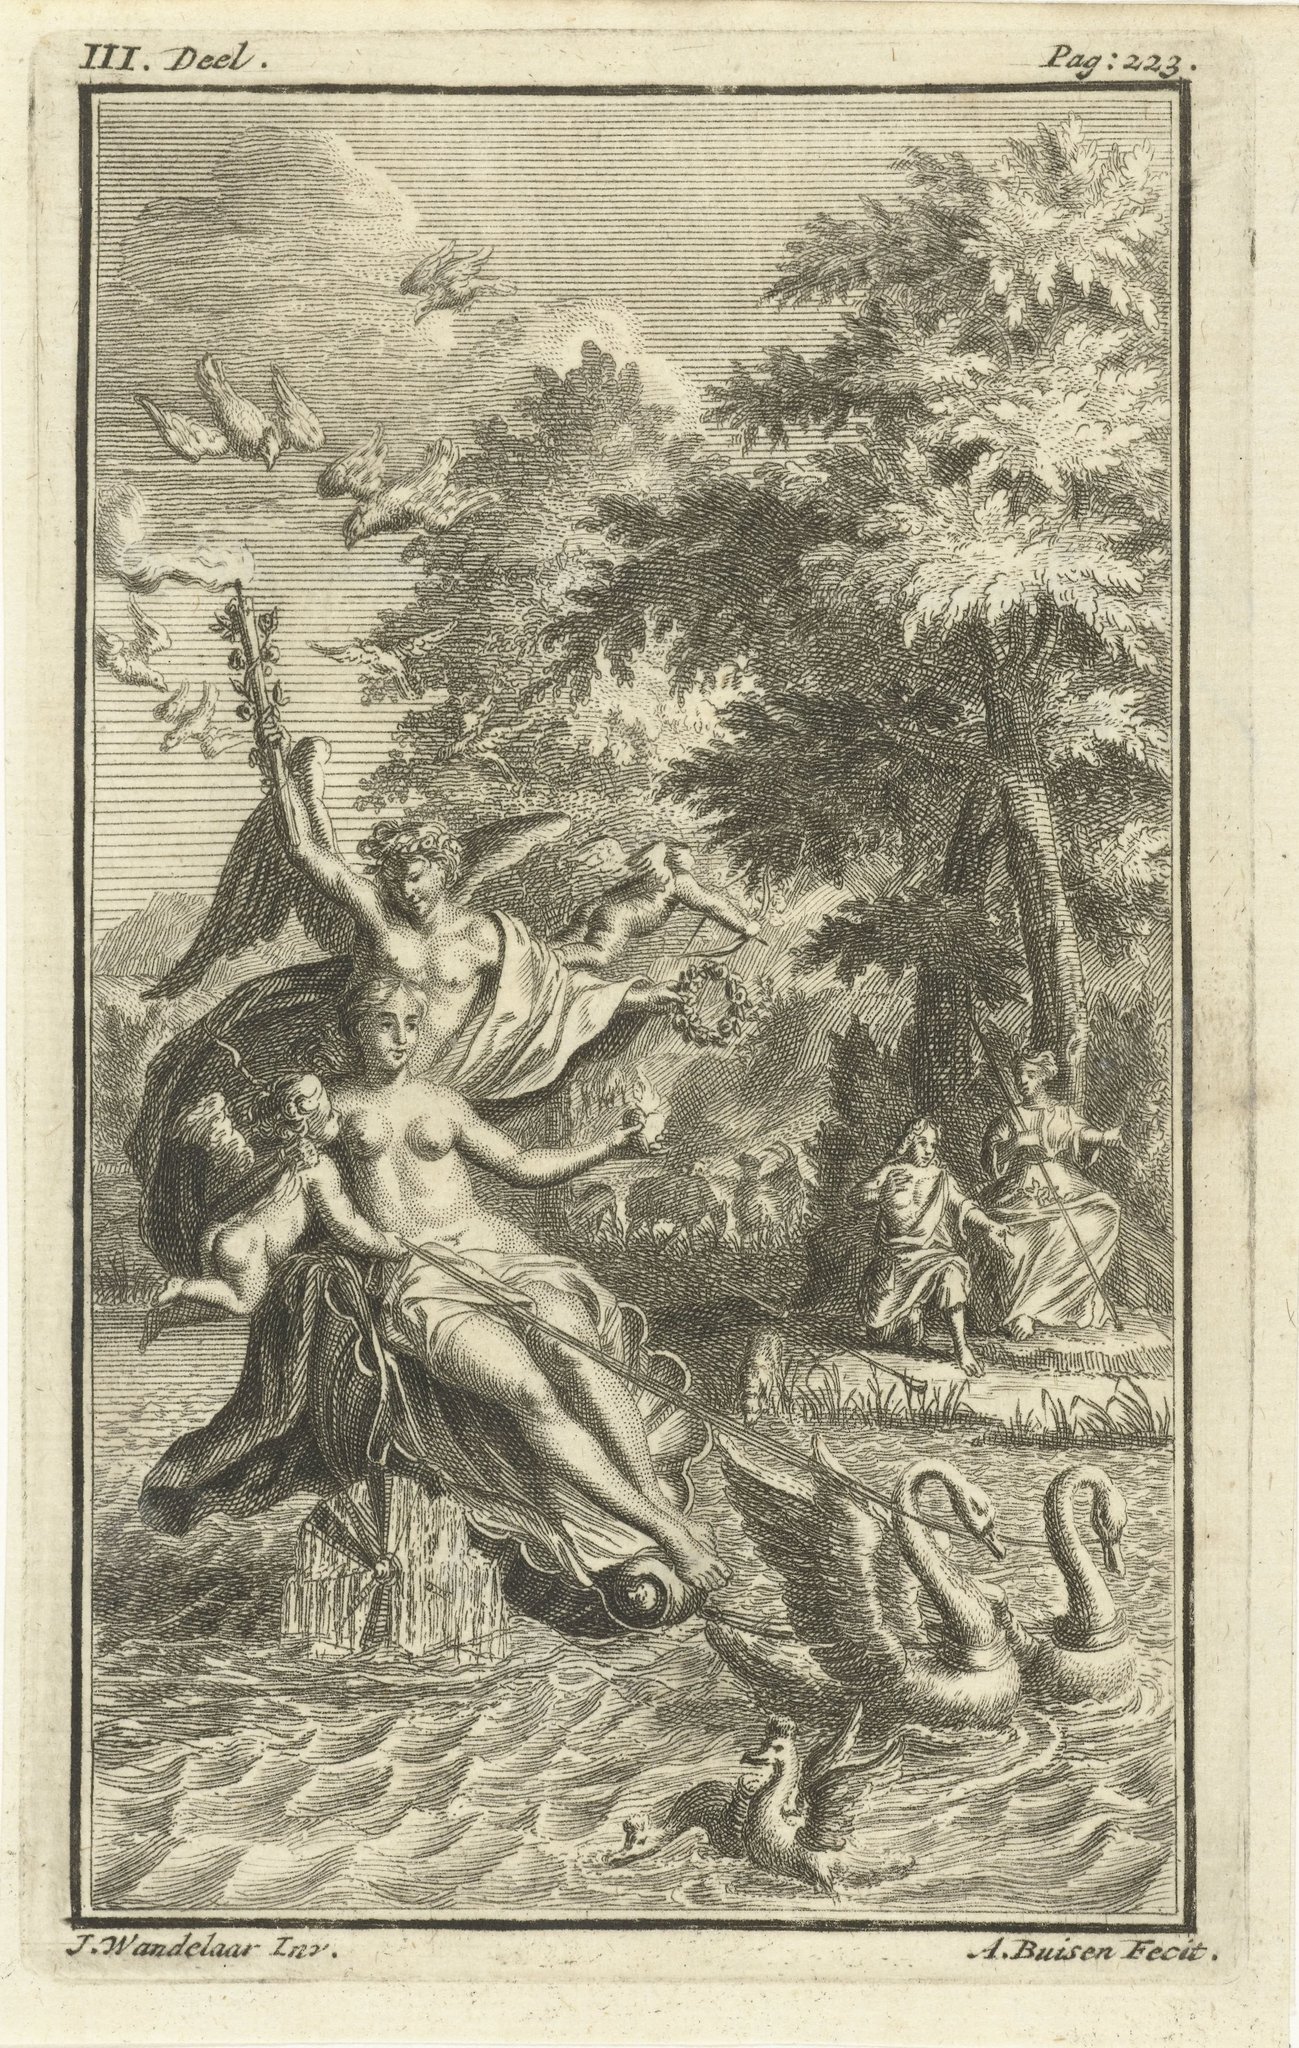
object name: print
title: Huwelijksaanzoek met Venus en Amor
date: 1723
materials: paper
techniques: engraving, etching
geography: amsterdam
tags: cupid shooting a dart, man kneeling before his beloved (proposing), venus and cupid (cupid not being mere attribute)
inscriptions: collector's mark: Lugt 2228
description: Venus rijdt in haar wagen getrokken door twee zwanen over het water. Ze houdt een brandend haart in haar hand. Aan de oever van het meer is een paar te zien. De man knielt voor de vrouw om haar een huwelijksaanzoek te maken. Amor schiet een van zijn pijlen op het paar af.